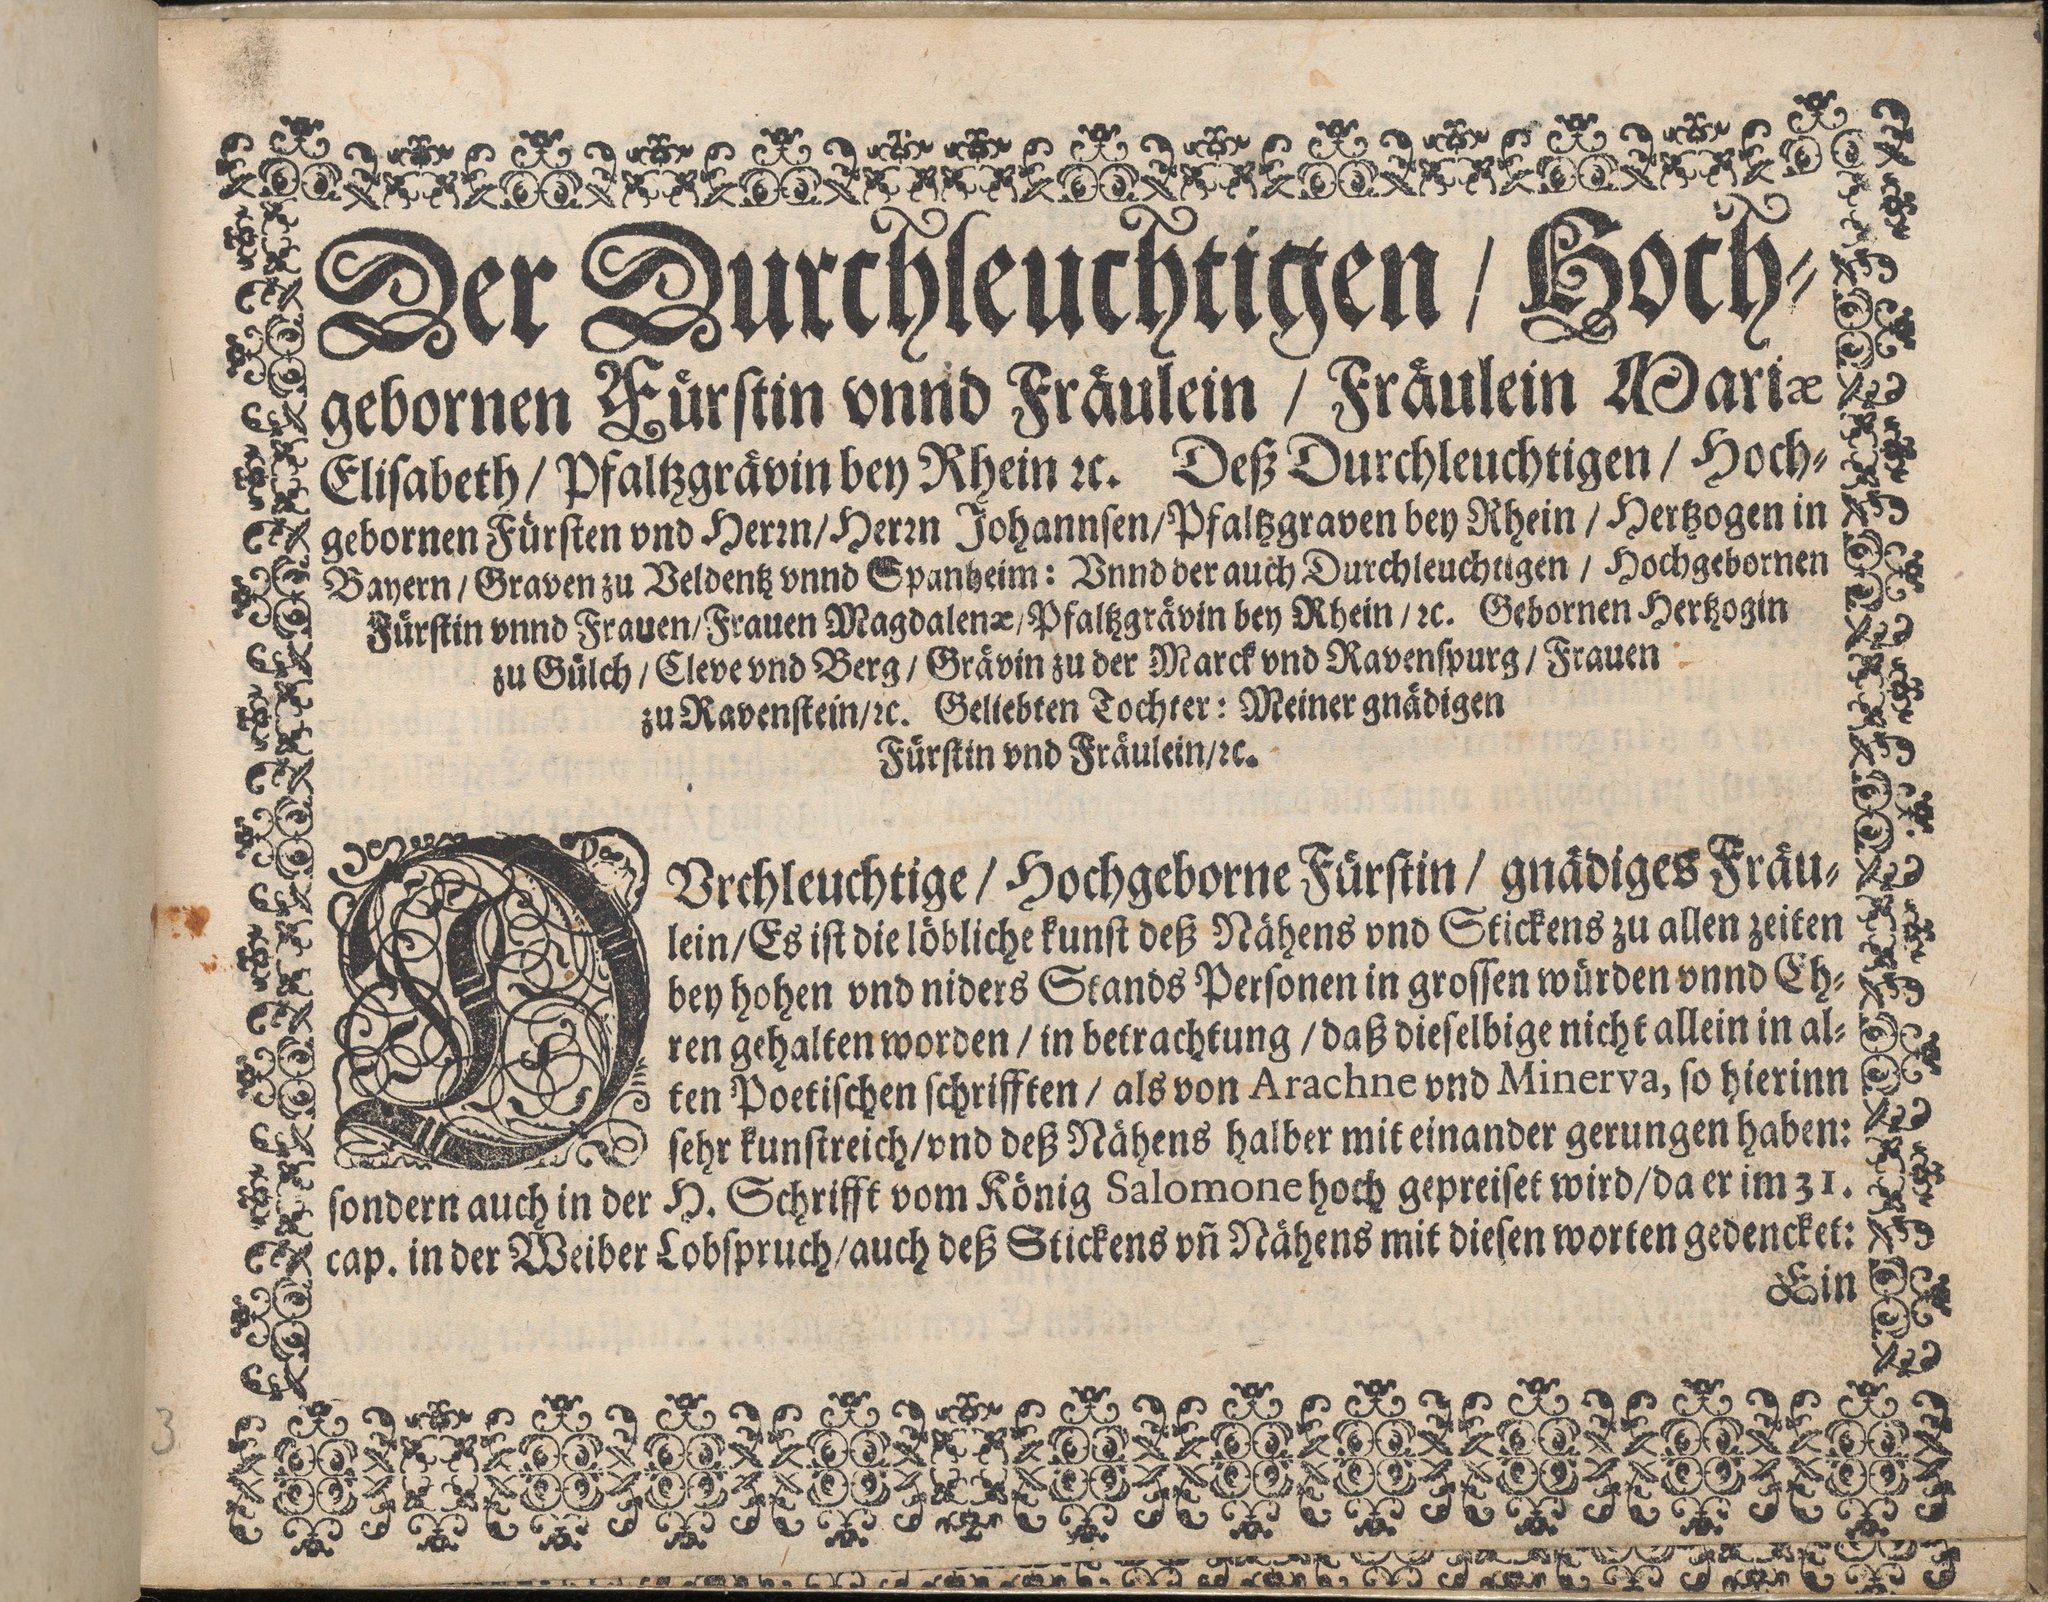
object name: book print ornament architecture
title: Newes Modelbuch in Kupffer (Page, 3r)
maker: johann sibmacher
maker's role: artist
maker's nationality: german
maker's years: 1590-1611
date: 1604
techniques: woodcut